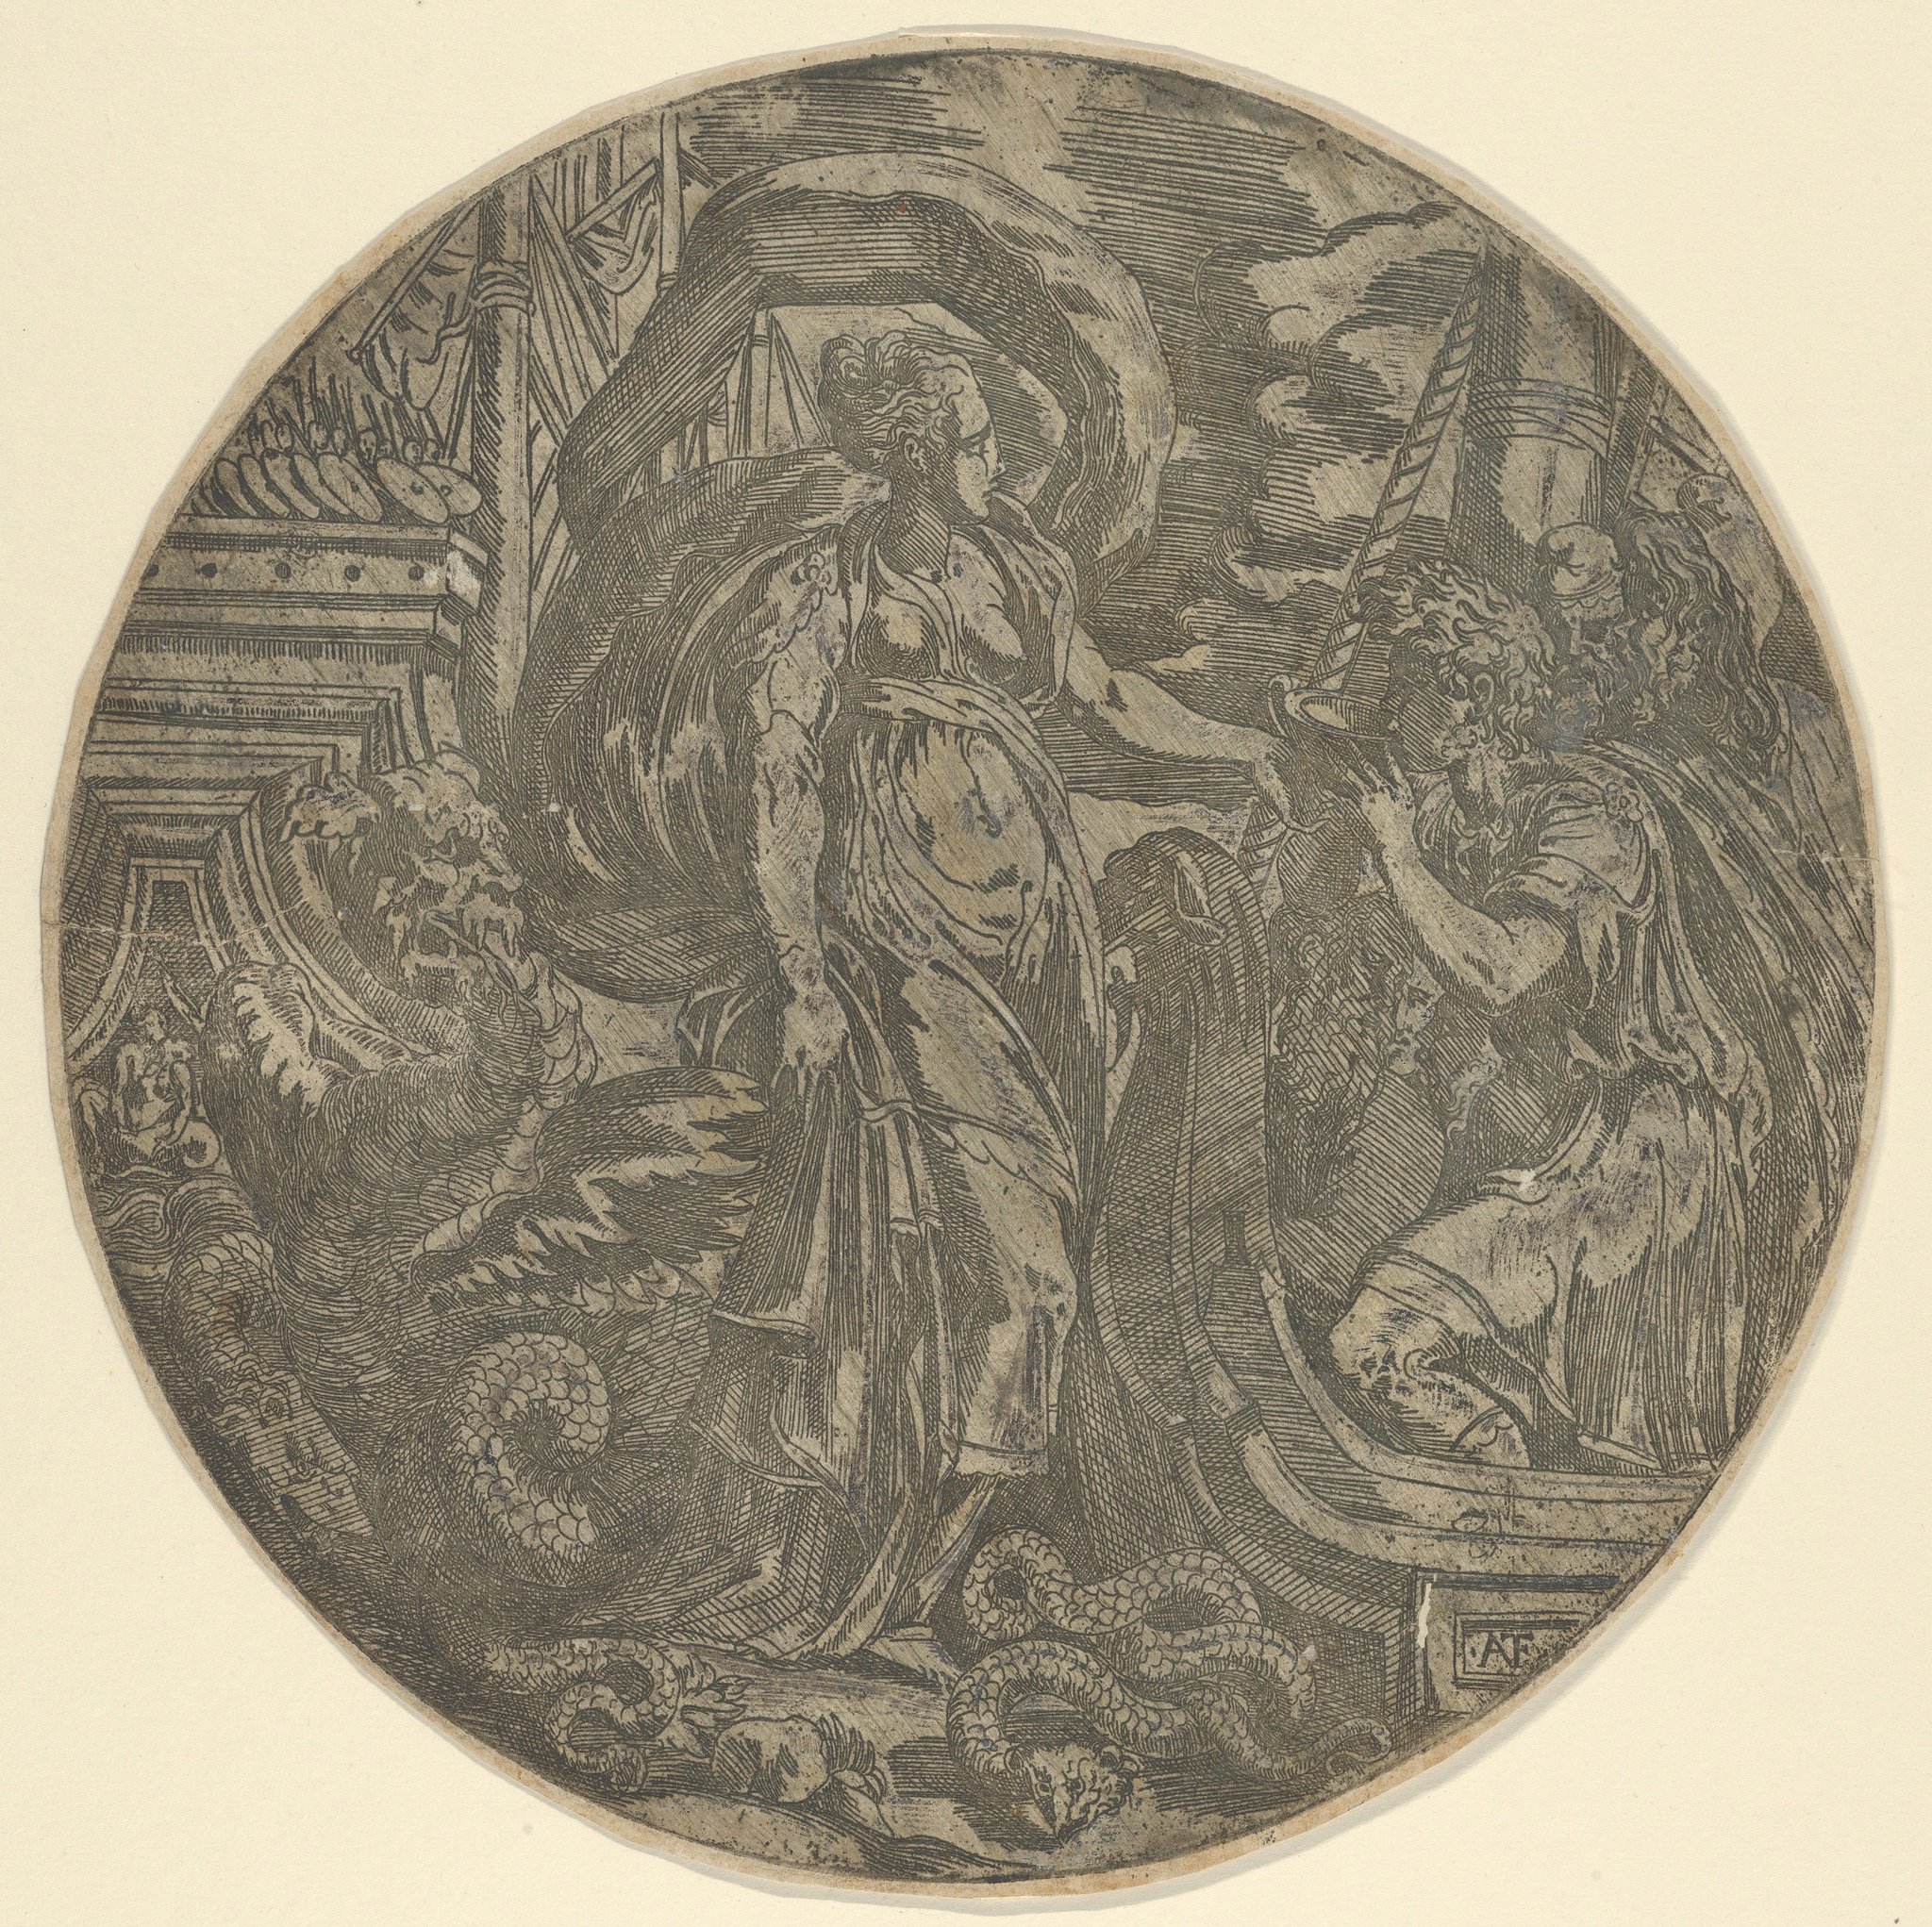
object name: print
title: Circe Giving a Drink to Ulysses's Companions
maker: antonio fantuzzi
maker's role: artist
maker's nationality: italian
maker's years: 1537-1545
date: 1540-1545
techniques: etching, heightening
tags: men,women,mythical creatures,boats